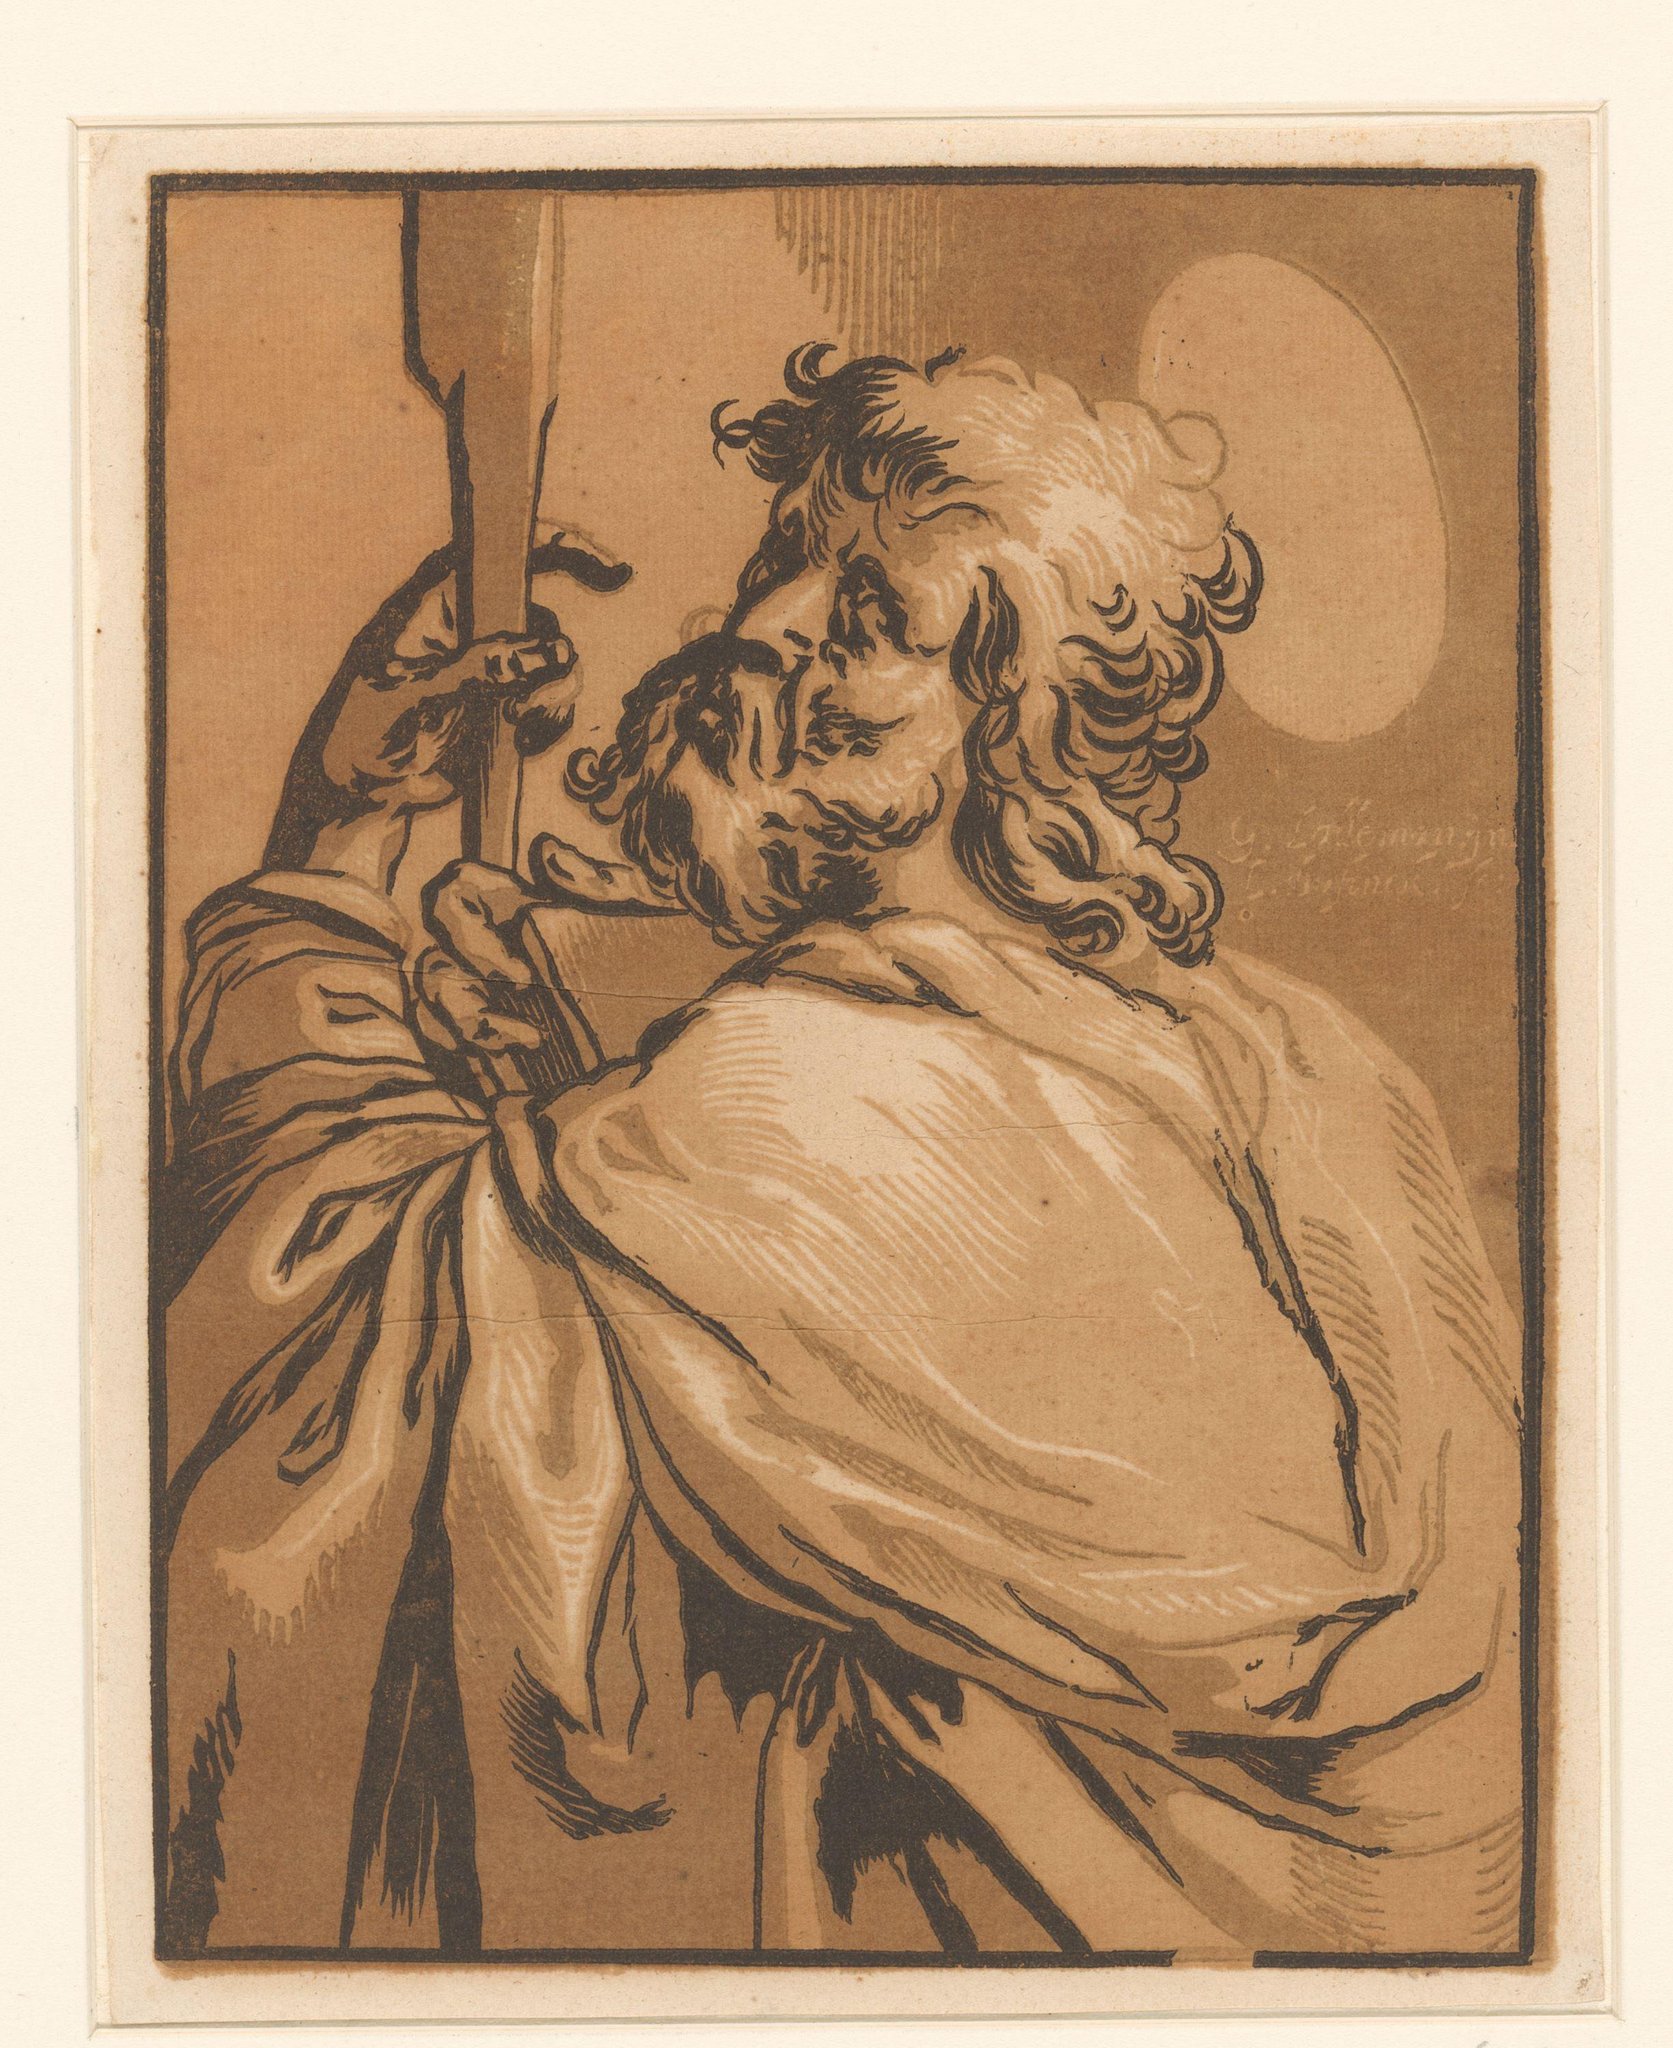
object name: print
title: Apostel Jakobus de Mindere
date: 1600-1669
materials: paper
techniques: woodcut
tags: the apostle james the less, first bishop of jerusalem; possible attributes: book, fuller's club, scroll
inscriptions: collector's mark: Lugt 240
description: Onderdeel van een serie van twaalf prenten met afzonderlijk Christus en de apostelen.